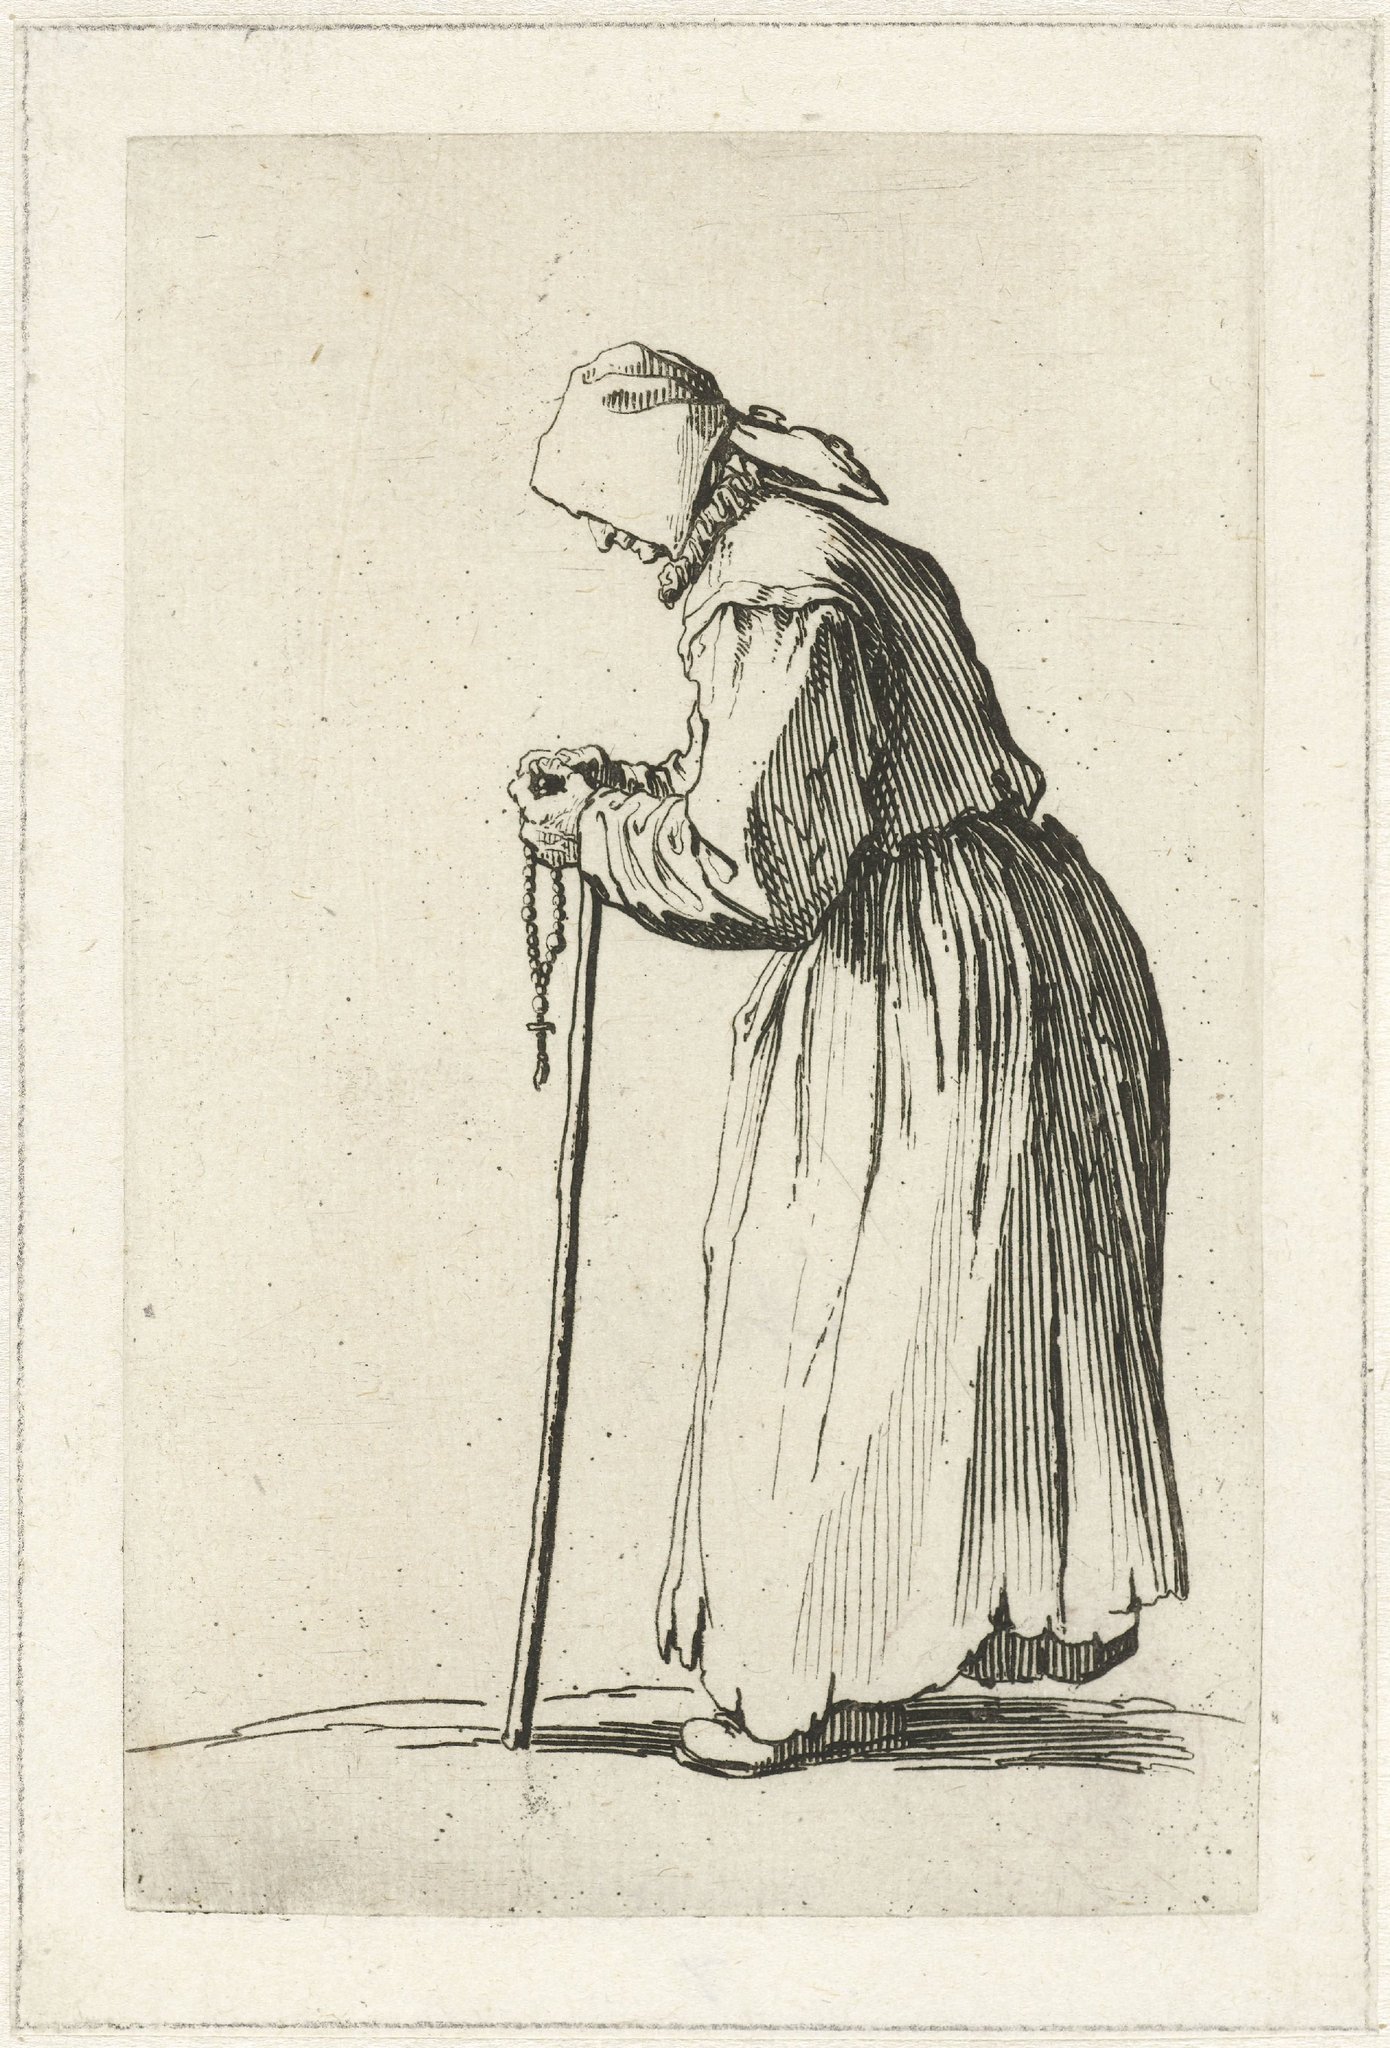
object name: print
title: Les Gueux / Les Mendiants / Les Baroni / Les Barons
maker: jacques callot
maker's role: draughtsman, print maker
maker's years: 1592-1635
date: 1622-1623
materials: paper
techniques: etching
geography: nancy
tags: aids for prayer, e.g. rosary, walking-stick, staff, beggar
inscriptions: collector's mark: Lugt 240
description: Vrouw, gekleed in lompen, op de linkerzijde gezien, een rozenkrans en een stok in de handen. Deze prent is onderdeel van een serie van 25 prenten met bedelaars en zwervers, zoals Callot die waarschijnlijk in Italië heeft gezien.